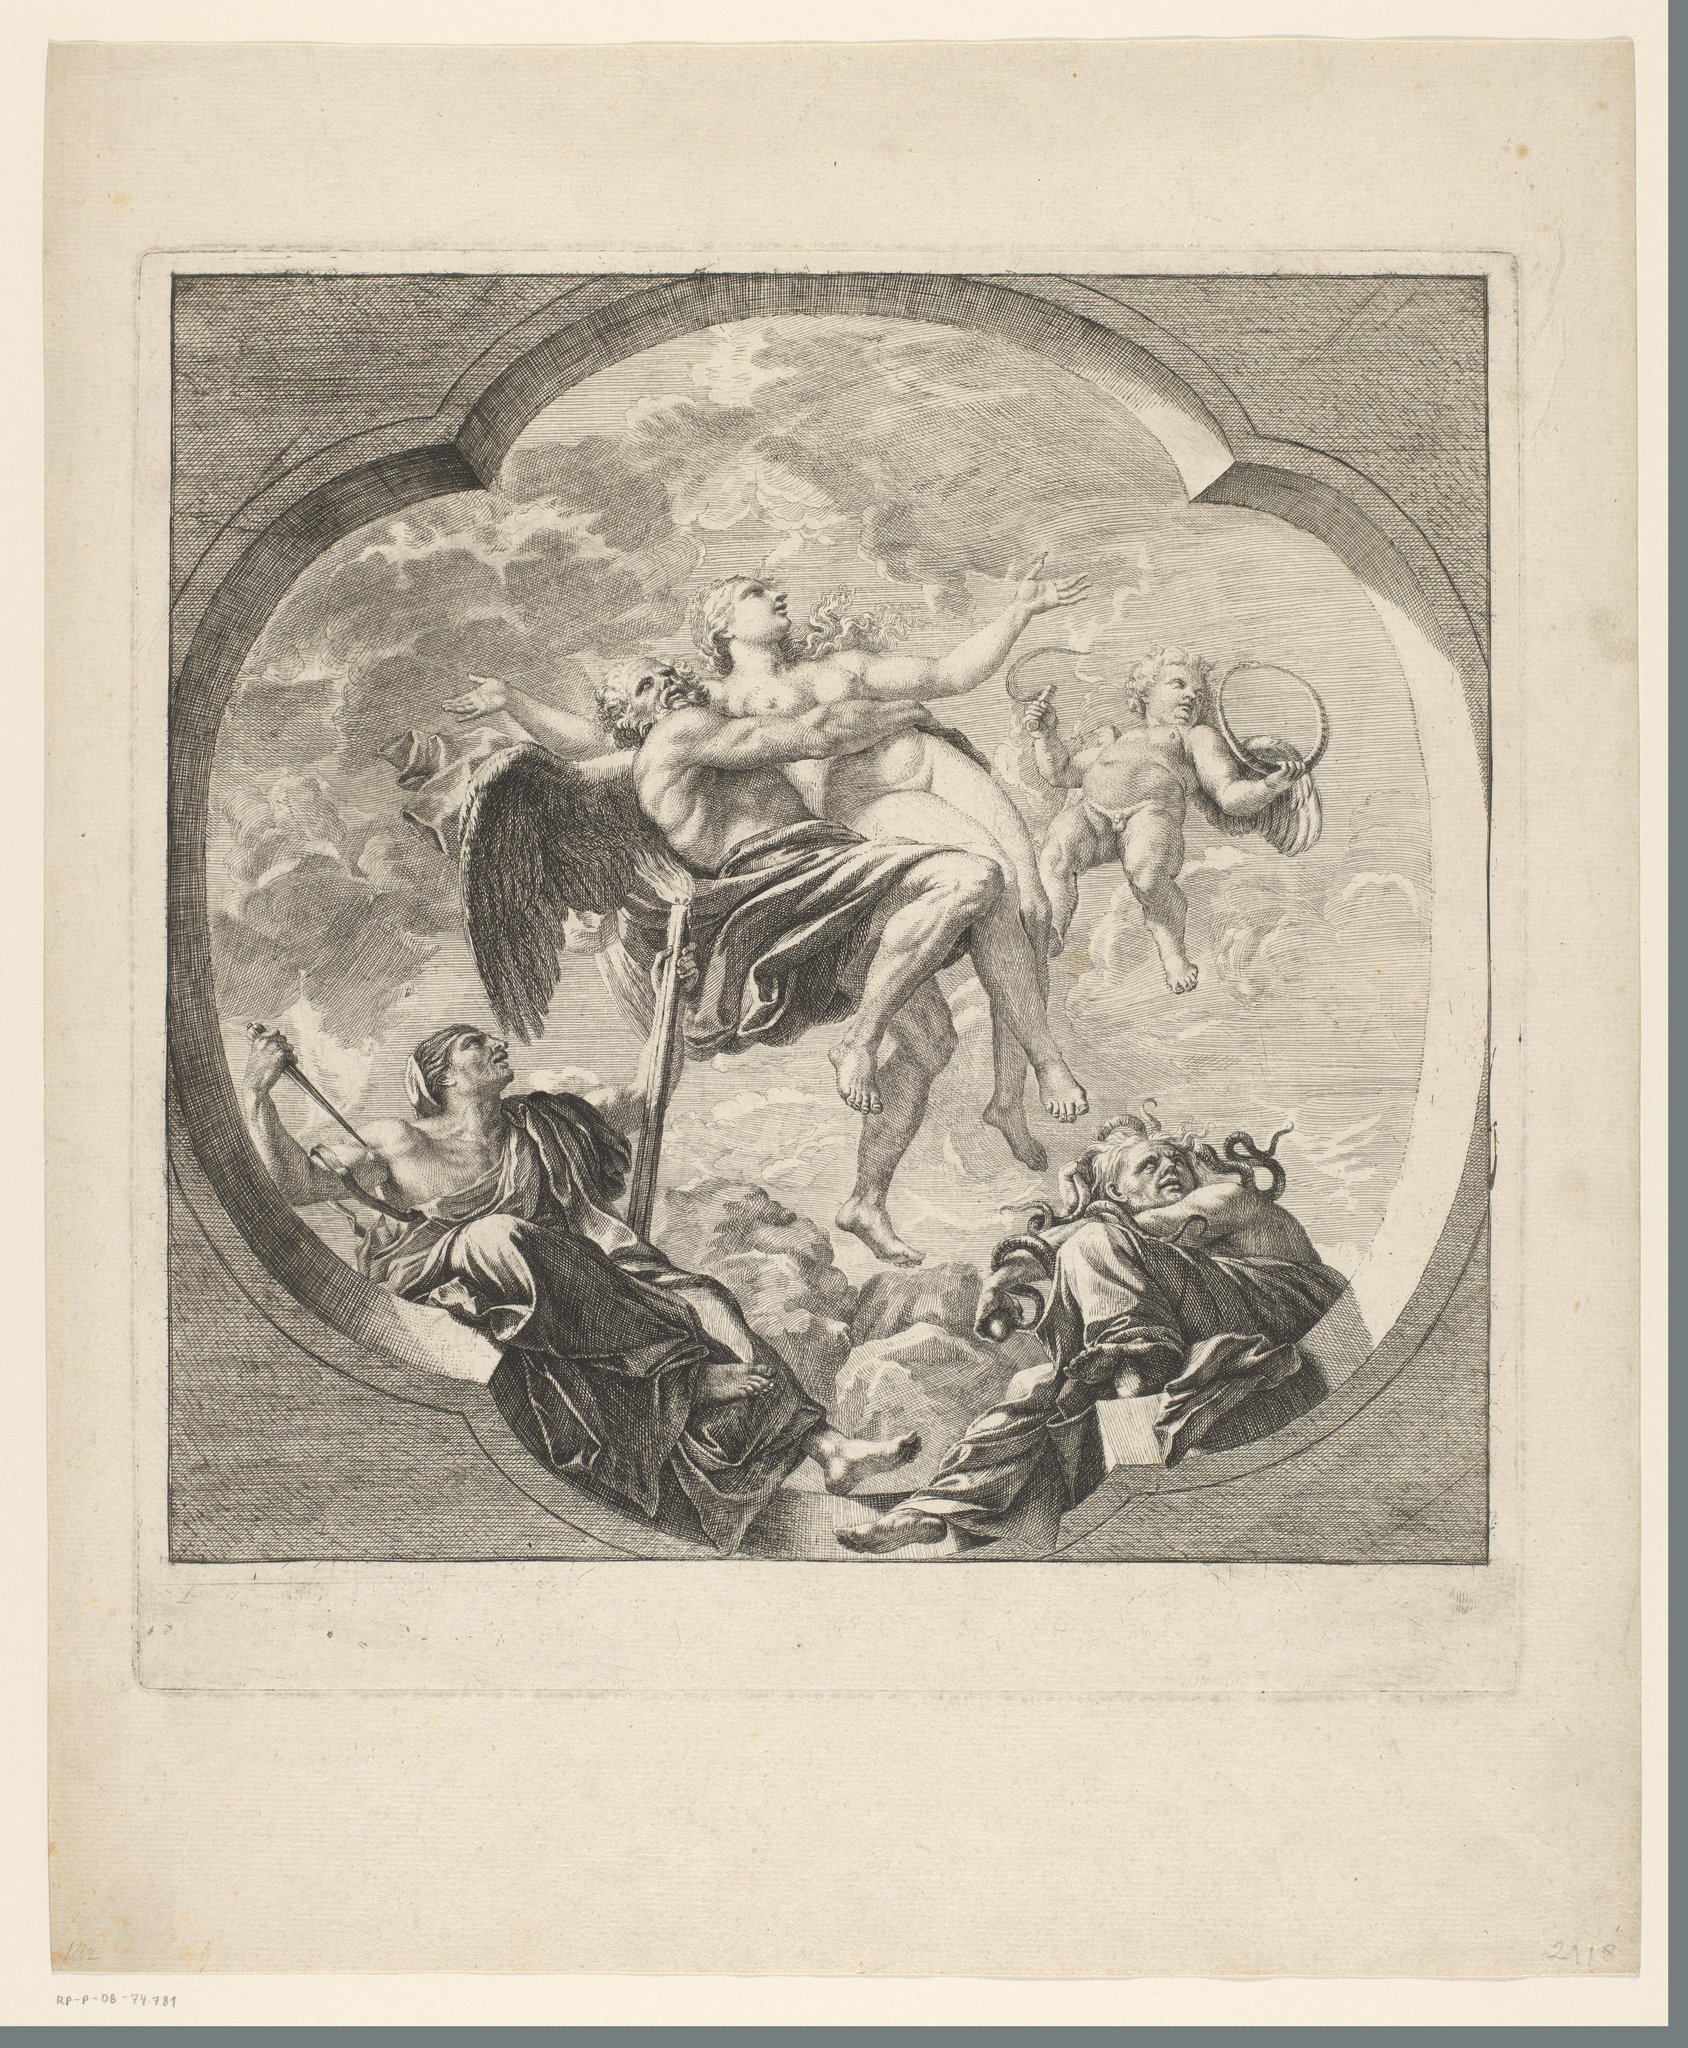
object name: print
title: Personificatie van de Tijd die de Waarheid onthult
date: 1650-1703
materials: paper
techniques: engraving, etching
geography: france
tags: time revealing truth; time carrying truth aloft, armorial bearing, heraldry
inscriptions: collector's mark: Lugt 2228